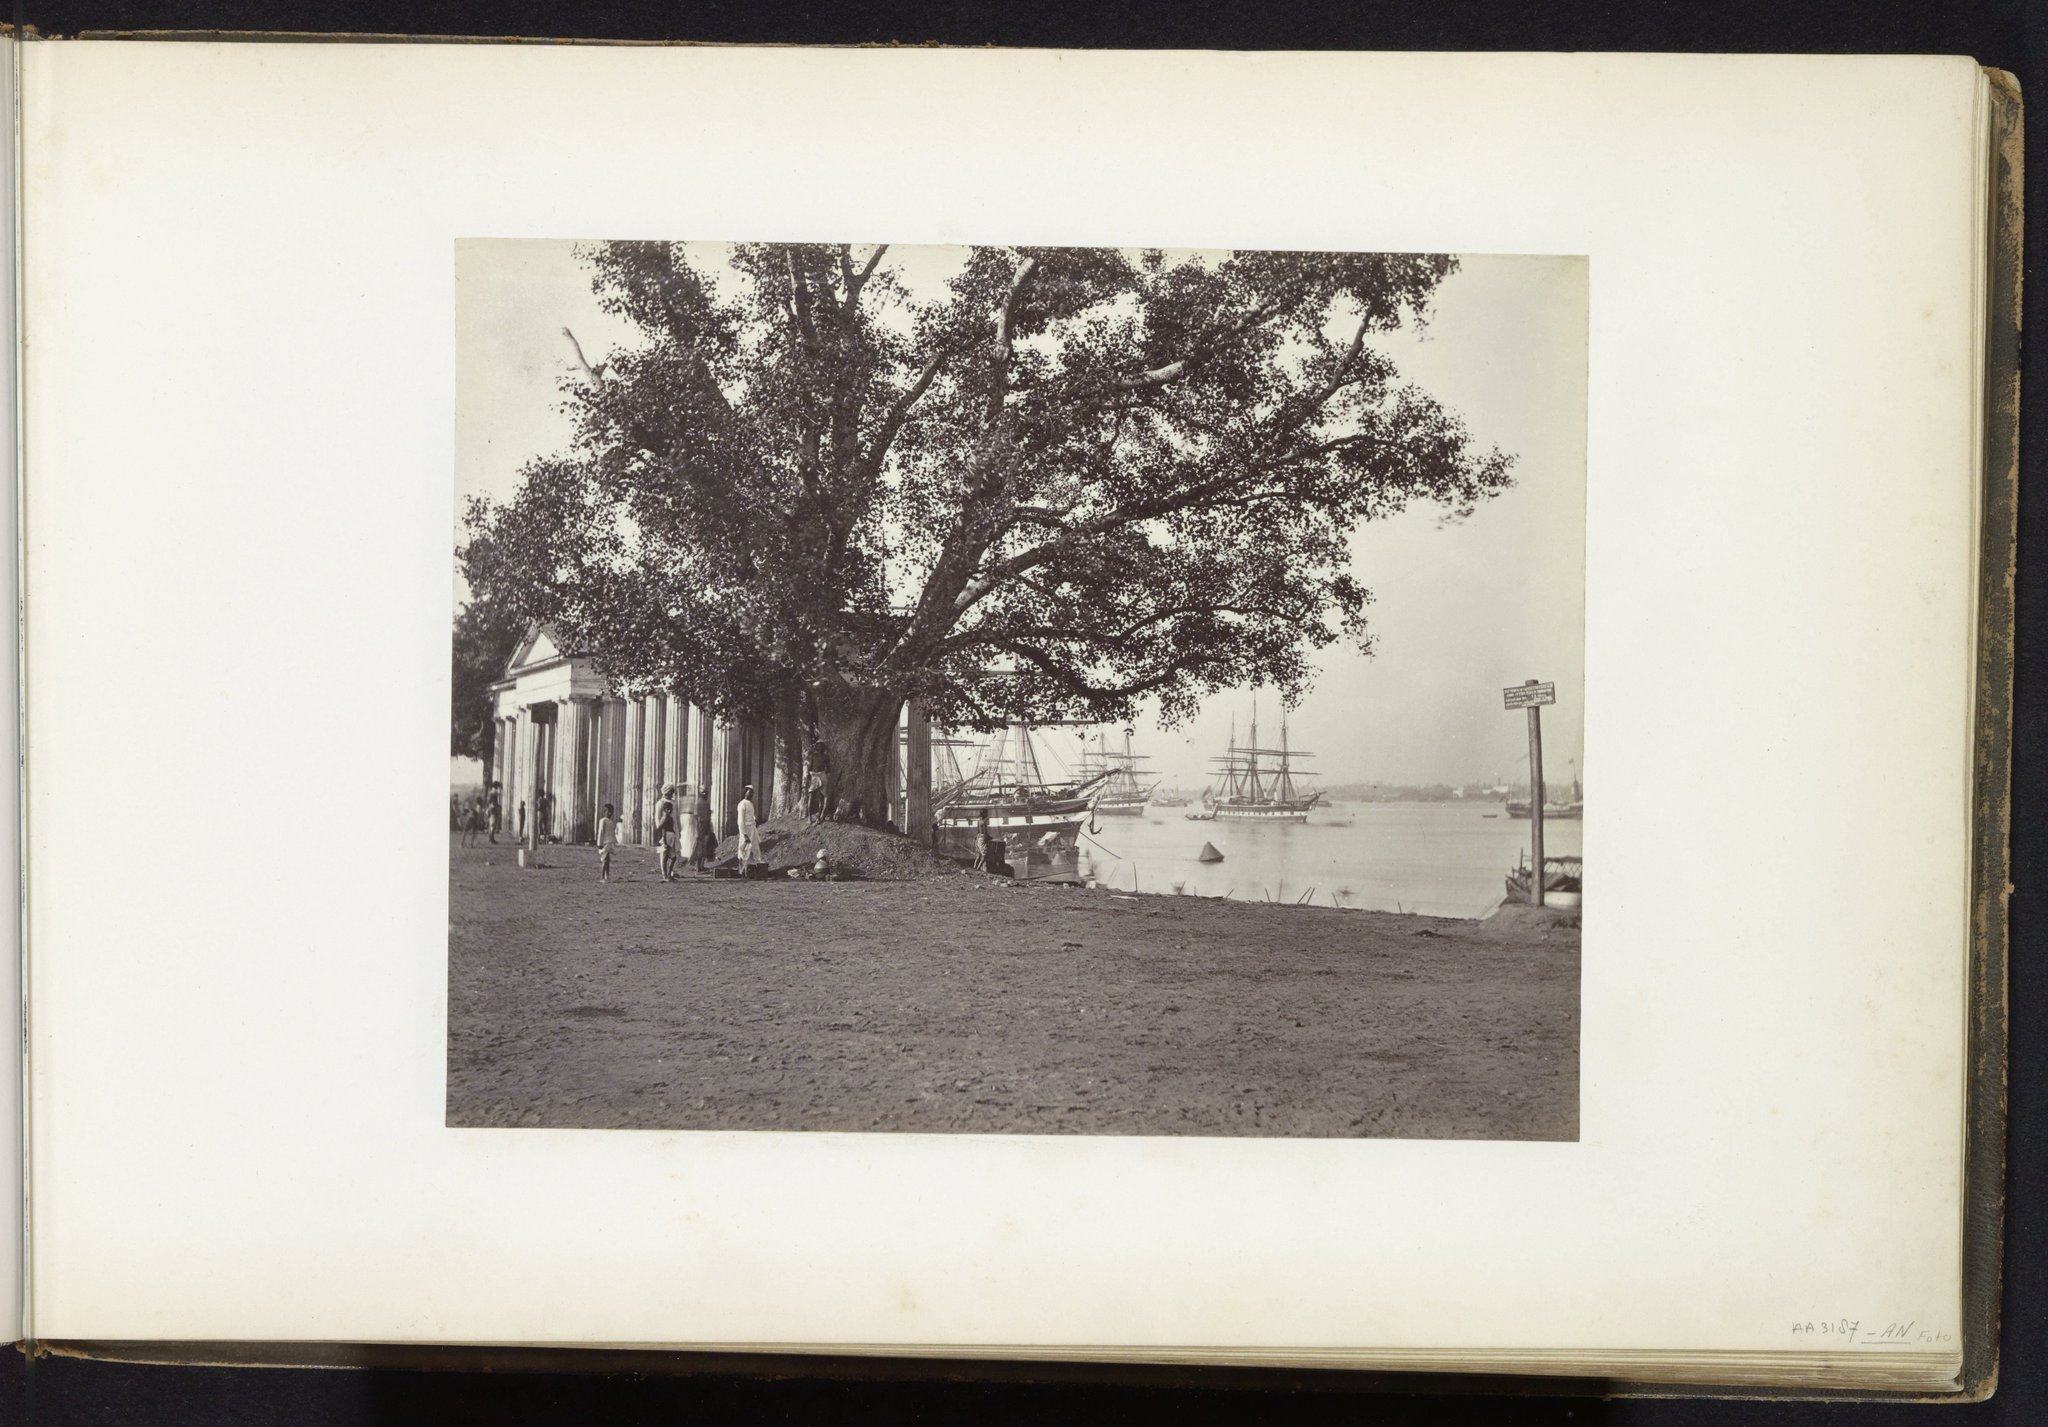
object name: photograph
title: Babu Ghat on the banks of the Hugli river in Kolkata, West Bengal, India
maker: Anonymous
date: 1865-1875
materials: paper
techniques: albumen print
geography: kolkata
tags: harbour (+ view ~ vehicle, ship, etc.)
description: Onderdeel van Reisalbum met opnames van bezienswaardigheden in India, Duitsland, Zwitserland en Frankrijk. De Babu Raj Chandra Ghat, kortweg Babu Ghat, werd in 1830 te Kolkata gebouwd door Rani Rashmoni, ter herinnering aan haar overleden echtgenote Babu Raj Chandra Das. De architectuur is neoklassiek, met Dorische zuilen. Tegenwoordig worden hier religieuze rituelen uitgevoerd.